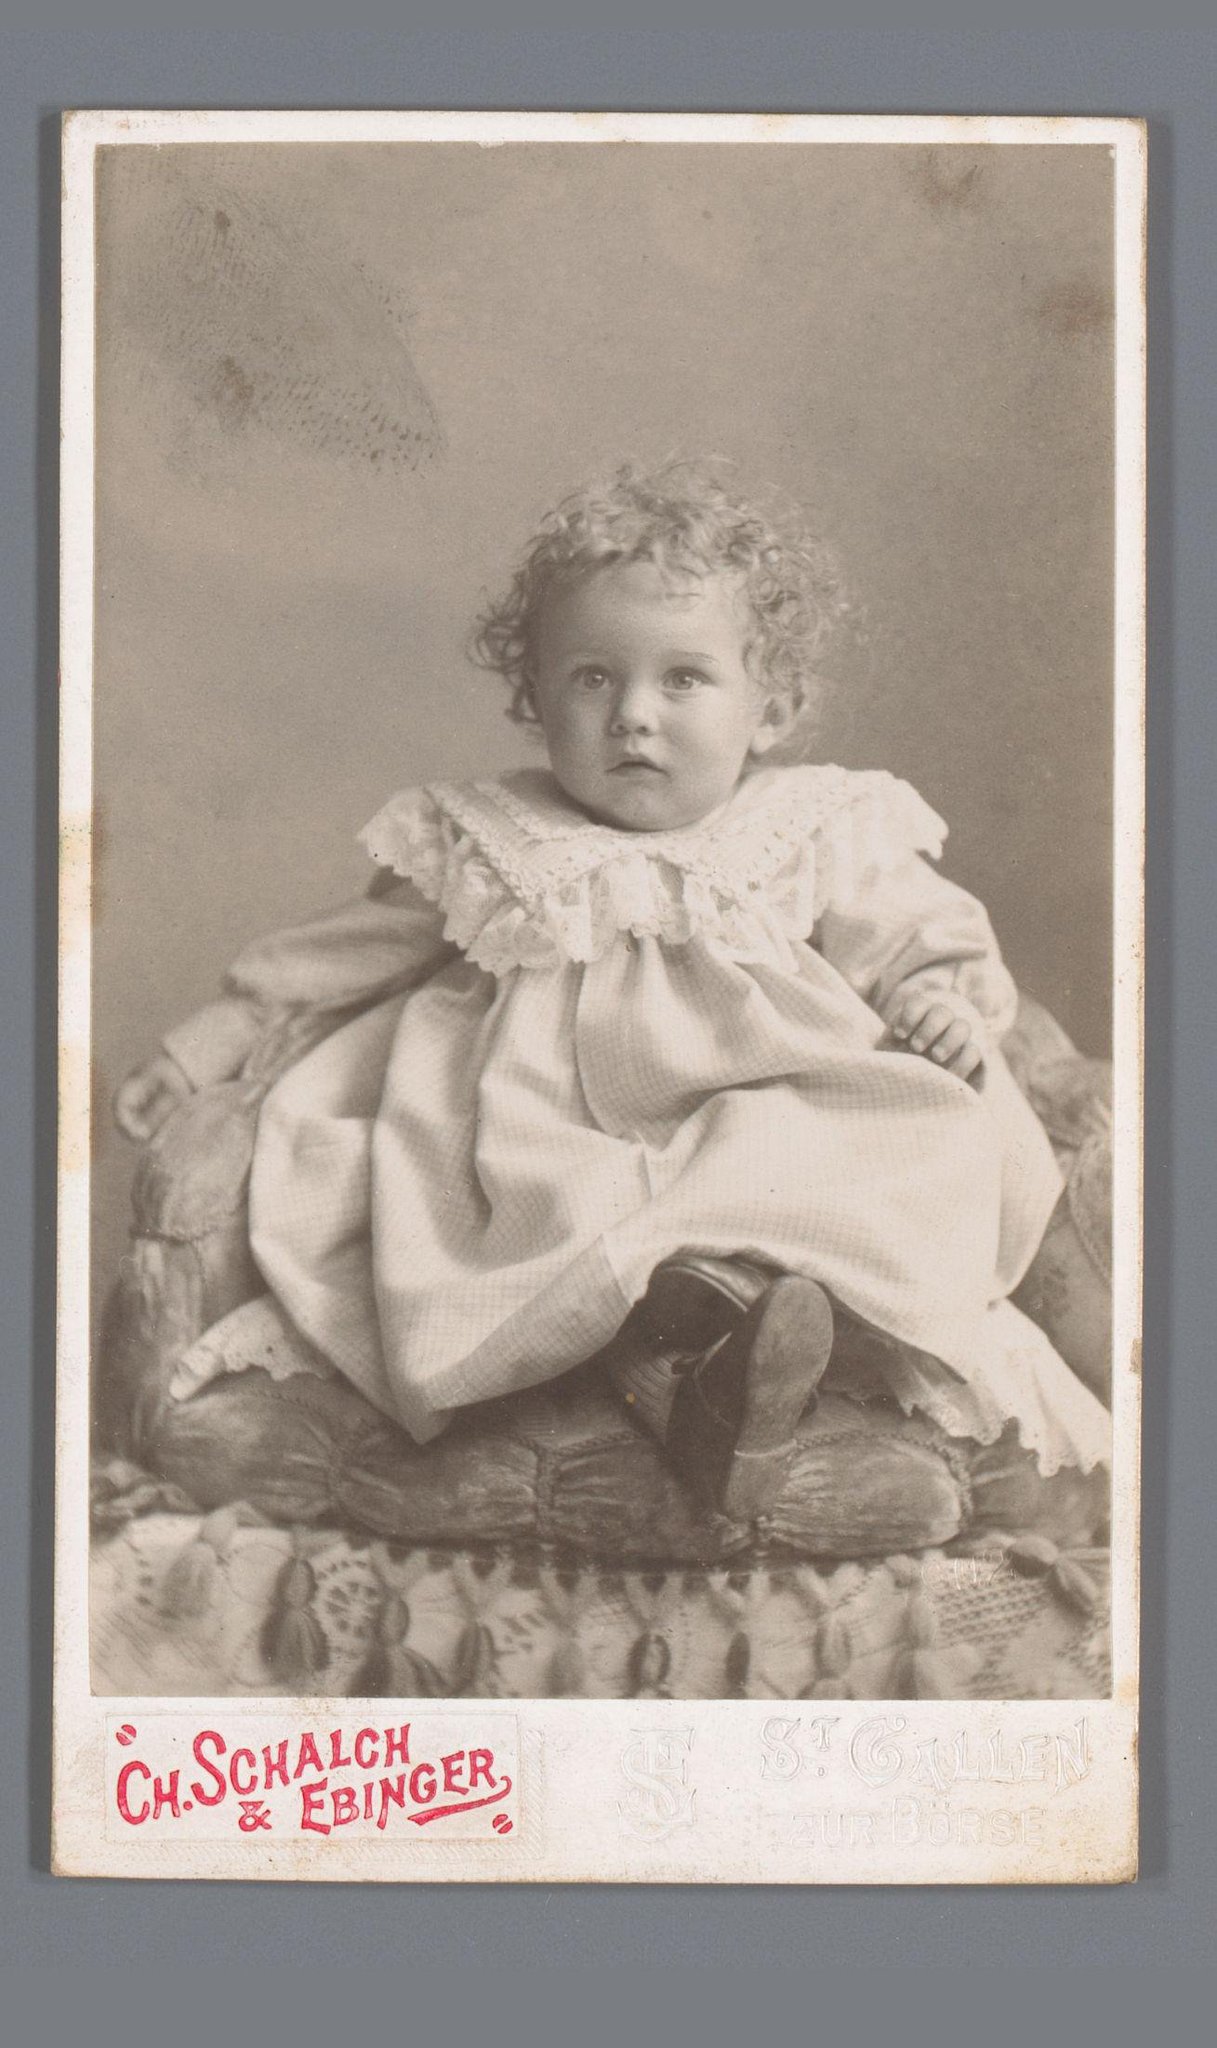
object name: carte de visite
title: Portret van een onbekend kind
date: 1898-1915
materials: paper, cardboard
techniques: gelatin silver print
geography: sankt gallen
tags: anonymous historical person portrayed, infant, baby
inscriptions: inscription: ‘St. Gallen/ Zur Börse/ TELEPHON 725/ Die Platte bleibt für Nachbestellungen aufbewahrt./ Vergrösserungen nach jedem Bilde bis Lebensgrösse/ B. P. GRIMAUD. PARIS.’